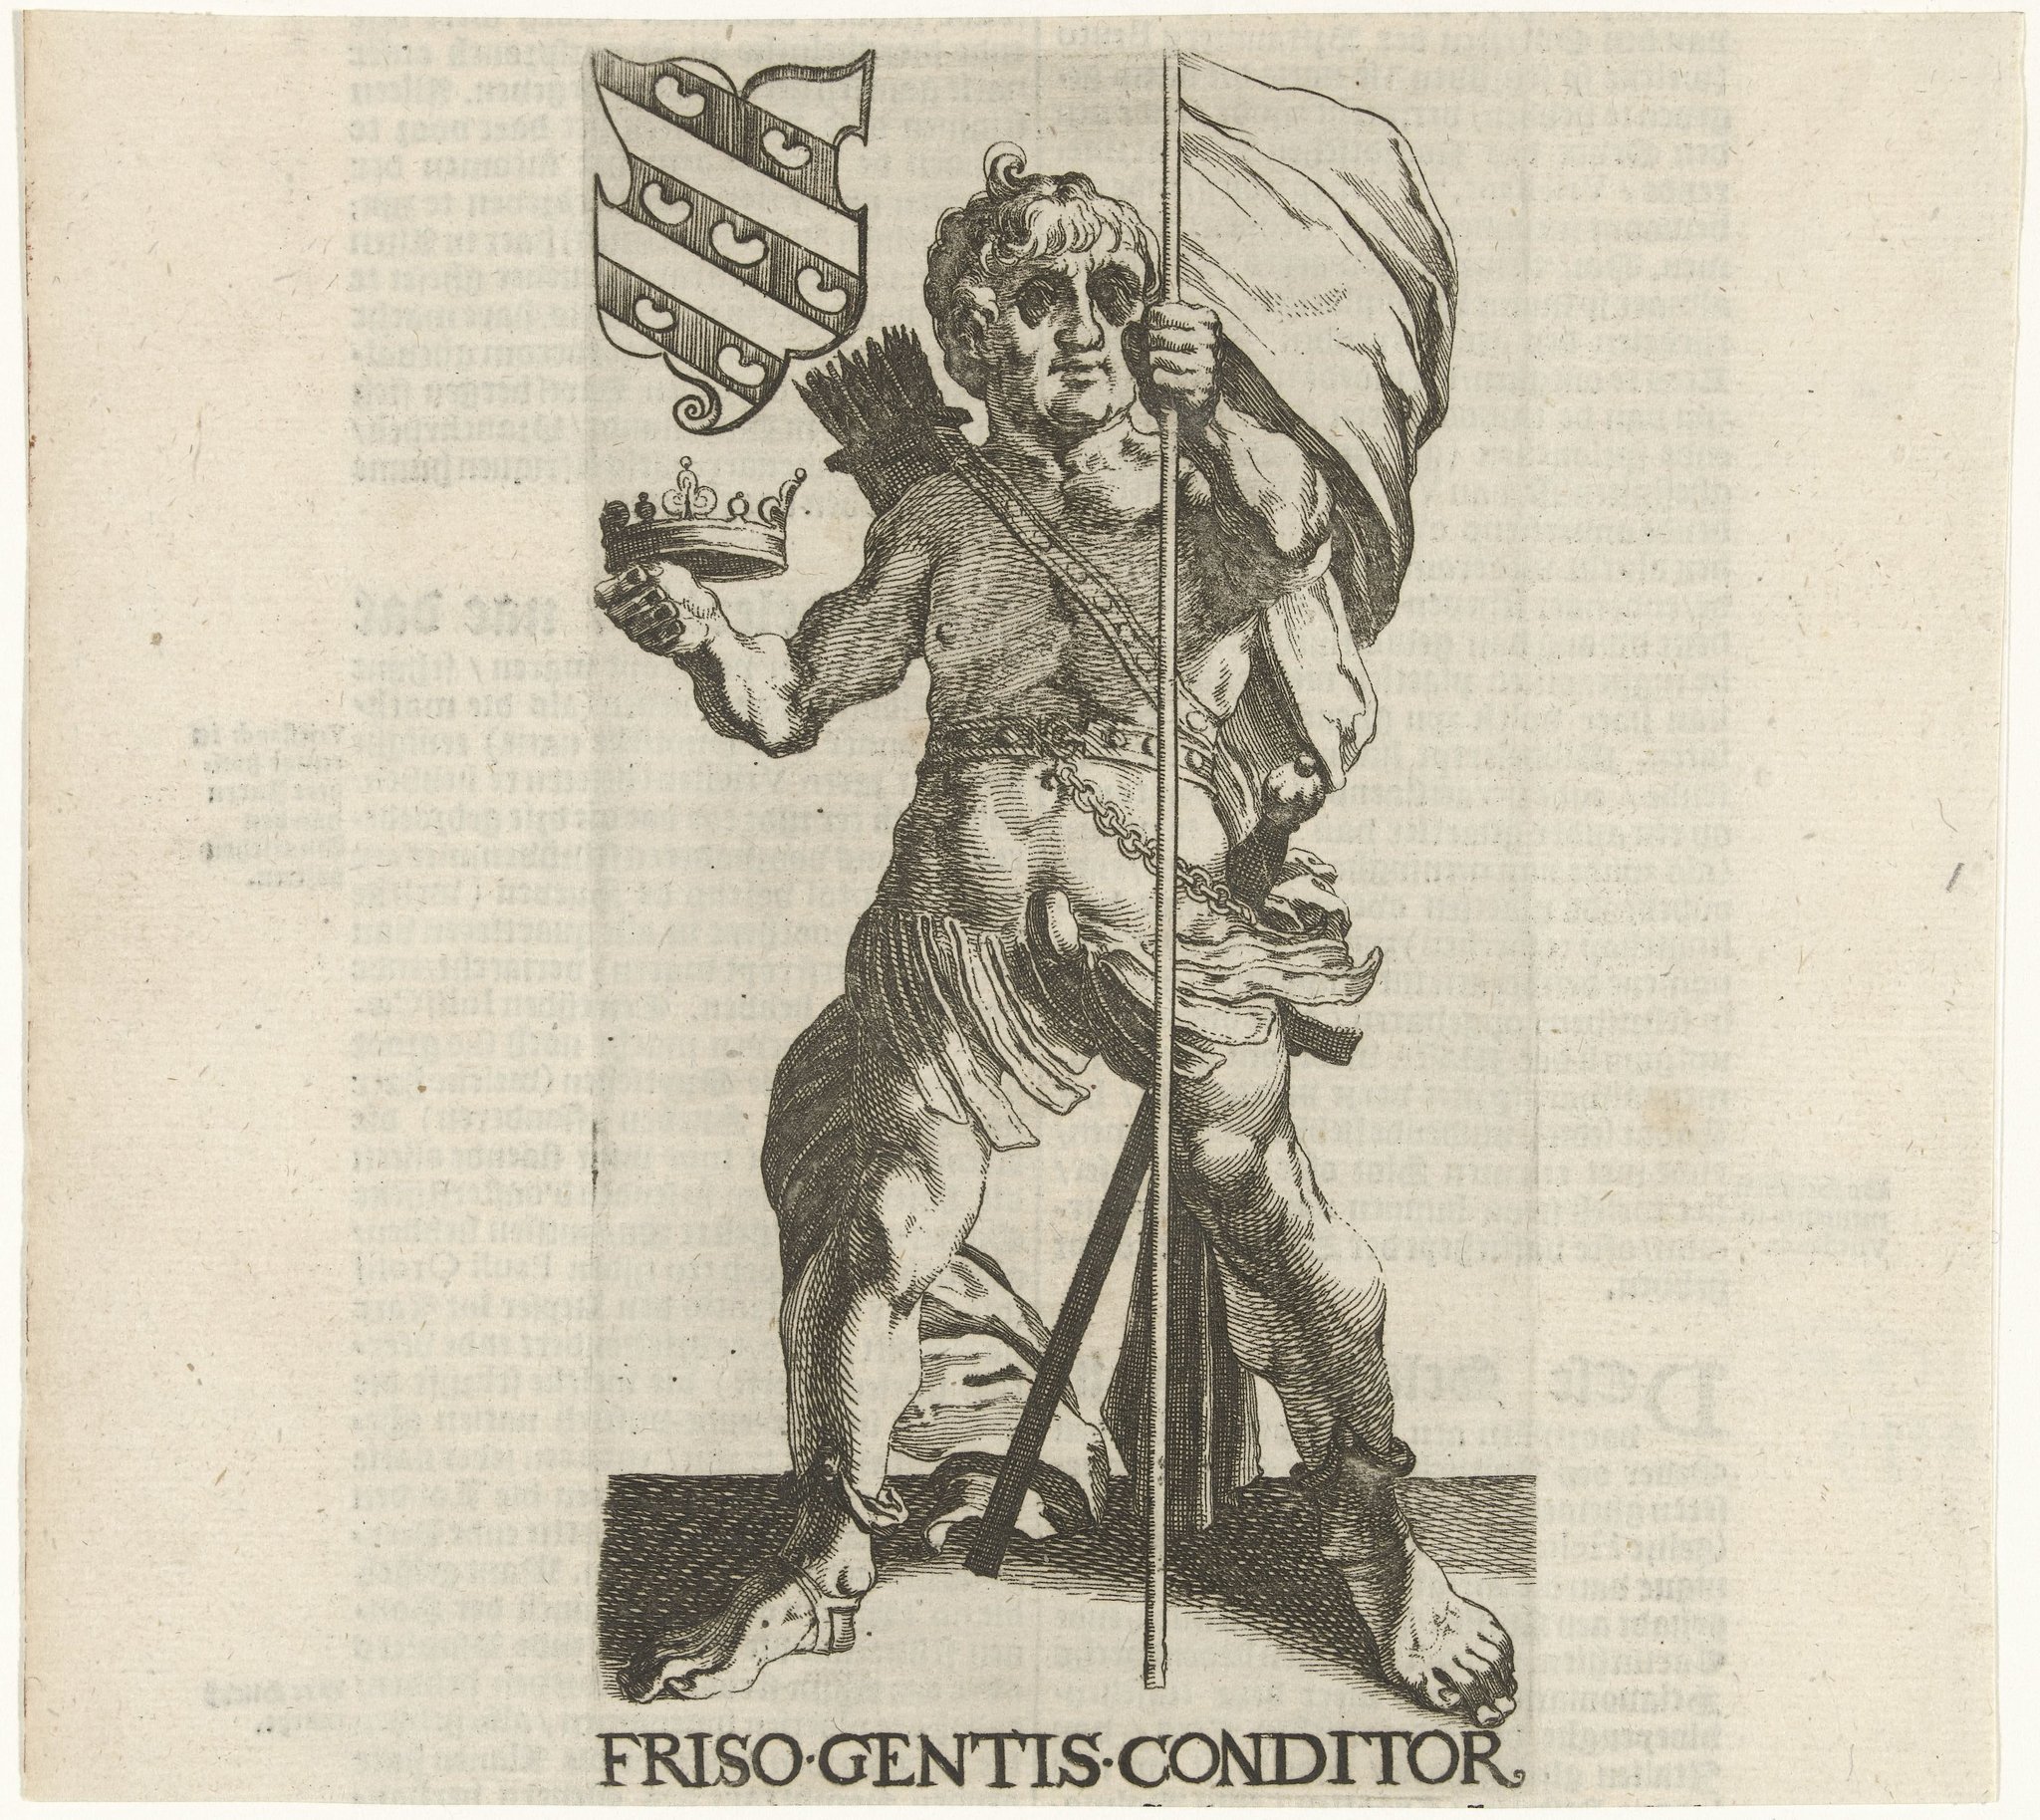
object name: print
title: Friese heersers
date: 1622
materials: paper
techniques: etching, letterpress printing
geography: franeker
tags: stamvader der friezen friso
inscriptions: collector's mark: Lugt 2228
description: De prent is ook als boekillustratie gebruikt in: Winsemius, P.W. Chronique ofte Historische geschiedenisse van Vrieslant (...). Franeker: Joannes Lamrinck, 1622.